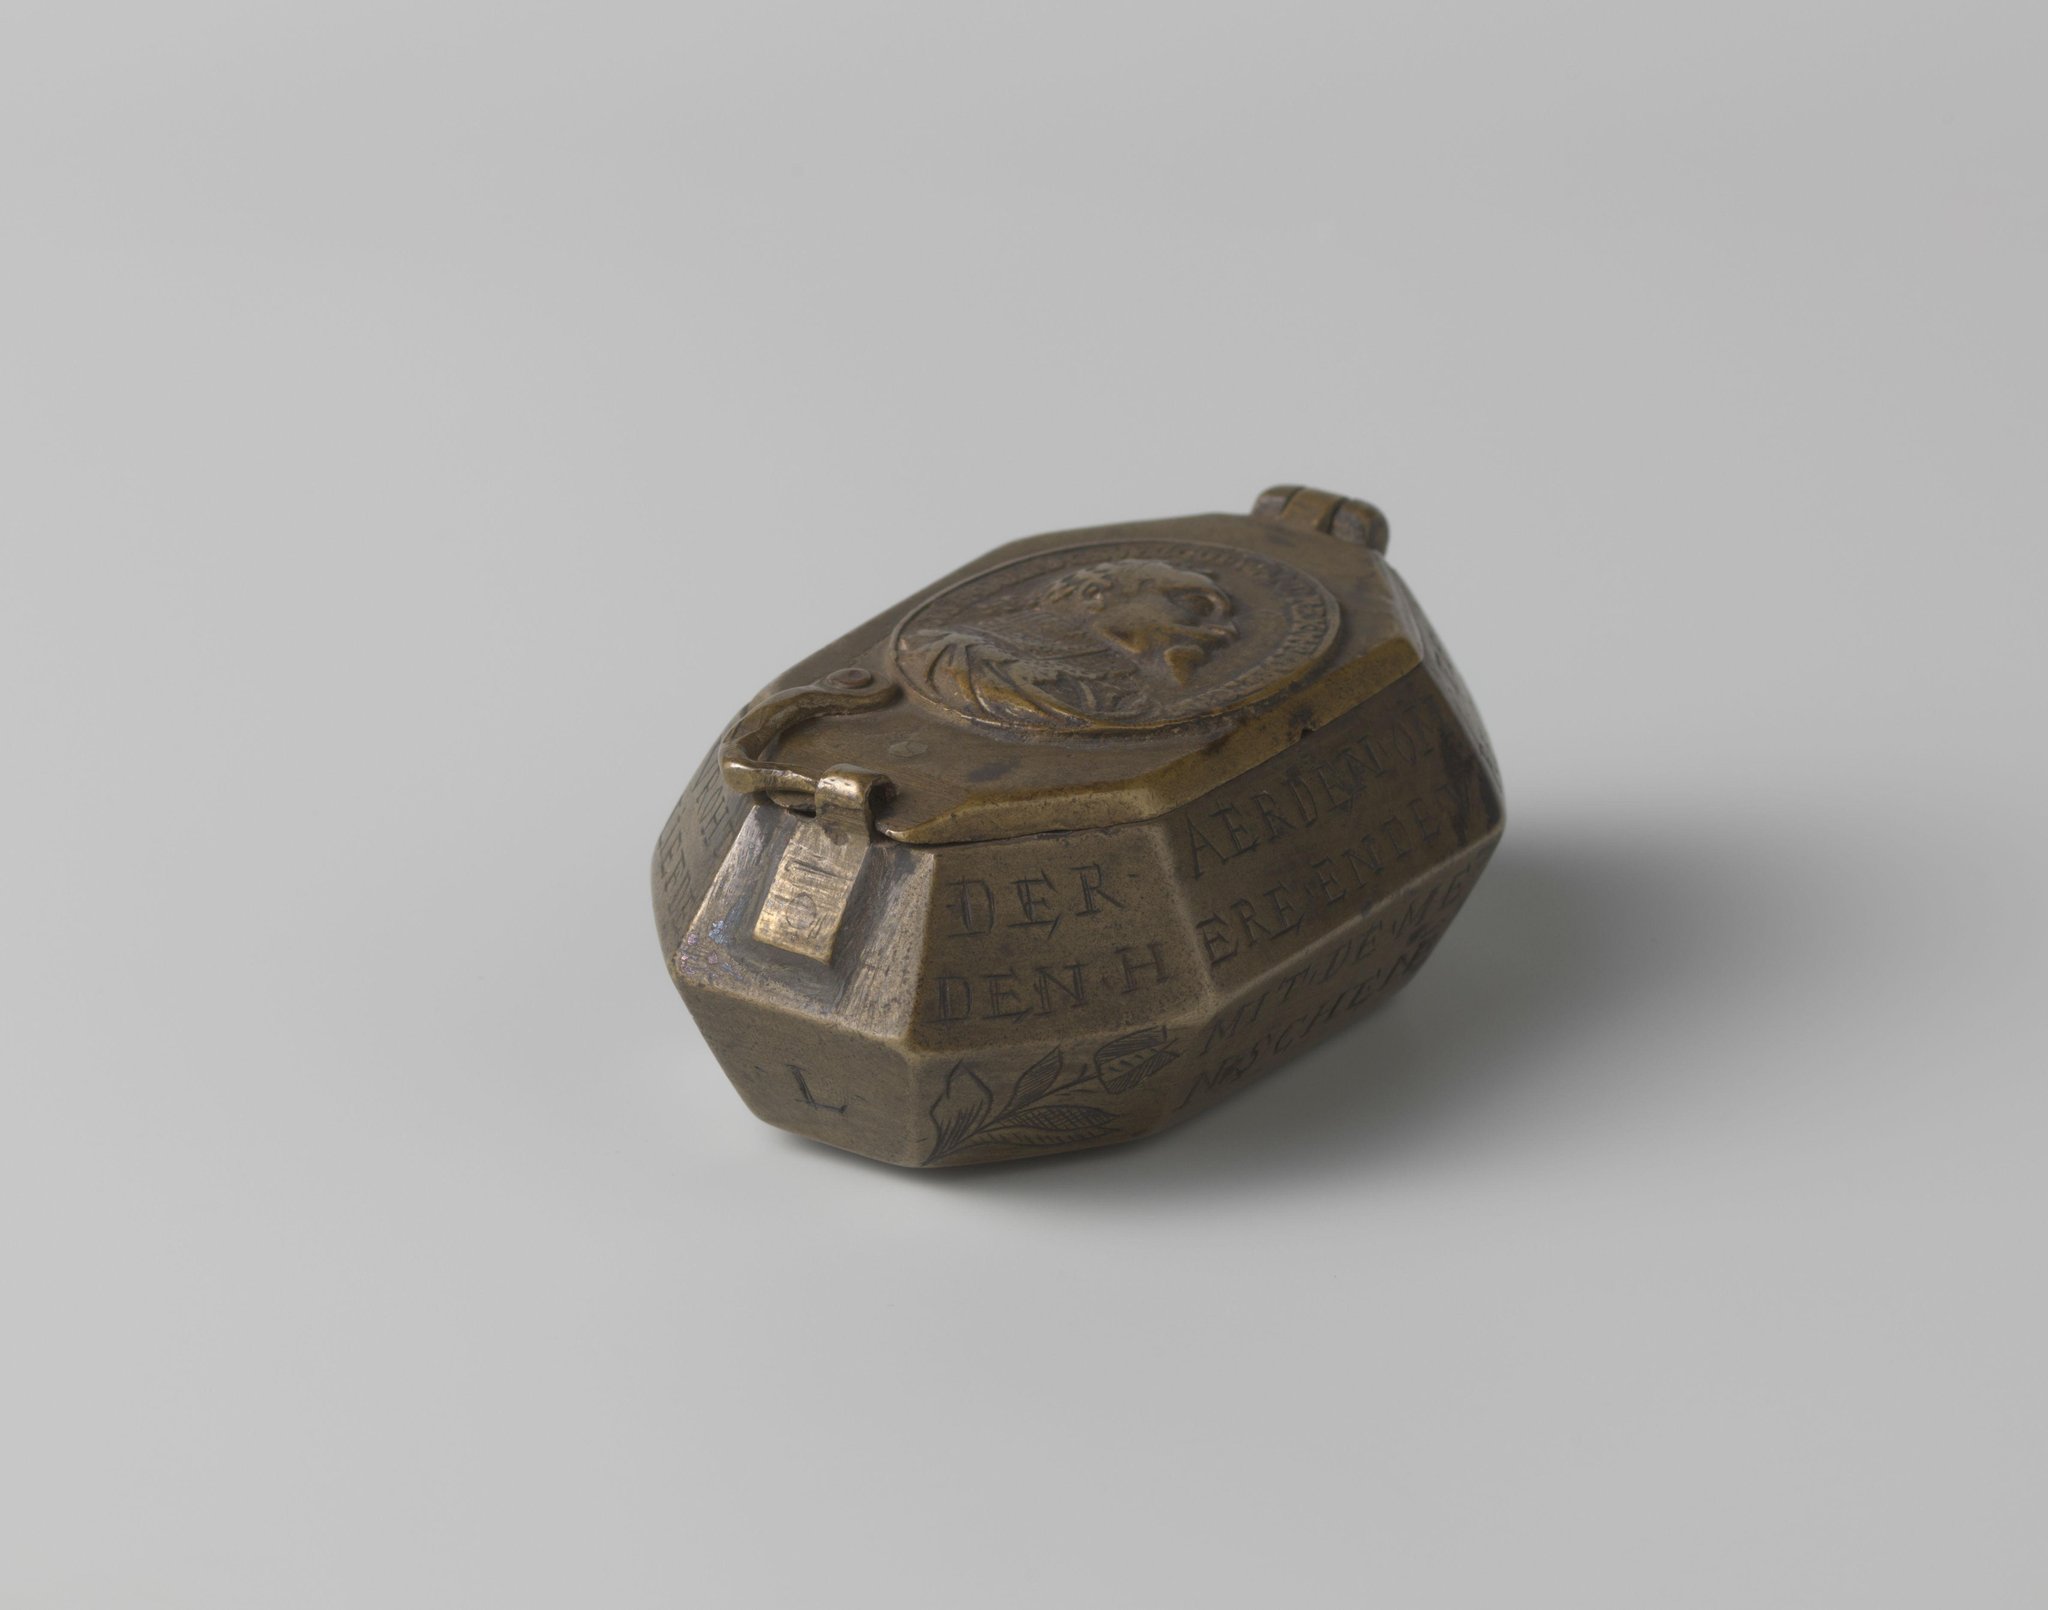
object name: box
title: Doosje van koper met portret van Gustaaf II Adolf van Zweden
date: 1631-1650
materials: copper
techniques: casting, engraving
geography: northern netherlands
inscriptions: inscription: ‘GUST.ADOLP.D-G.SVEC.GOT.WAND.REX.MPFDE.ET.CI’, inscription: ‘DEO.ET.VICTRICIBUS.ARMIS’, inscription: ‘WAT ISSER.MEDER VROHT DER.AERDEN.OM.TE WENSCHEN.ALS.LIEFDE DEN.HERE.ENDE.VREDE MIT.DE.MENSCHEN W A N L’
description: Achthoekig doosje van koper. De onderste helft gaat via een achthoekig vlak omgekeerd conisch omhoog in een scherpe lijn, waarna de bovenste helft met een scherpe bocht conisch toeloopt. De bovenzijde wordt afgesloten met een achthoekig deksel met daarop het portret Gustaaf II Adolf van Zweden in een ovaal medaillon. Op de onderzijde is een staande leeuw in een ovaal medaillon afgebeeld met schild en zwaard. Op de zijkanten is een tekst aangebracht temidden van enkele bloemen.